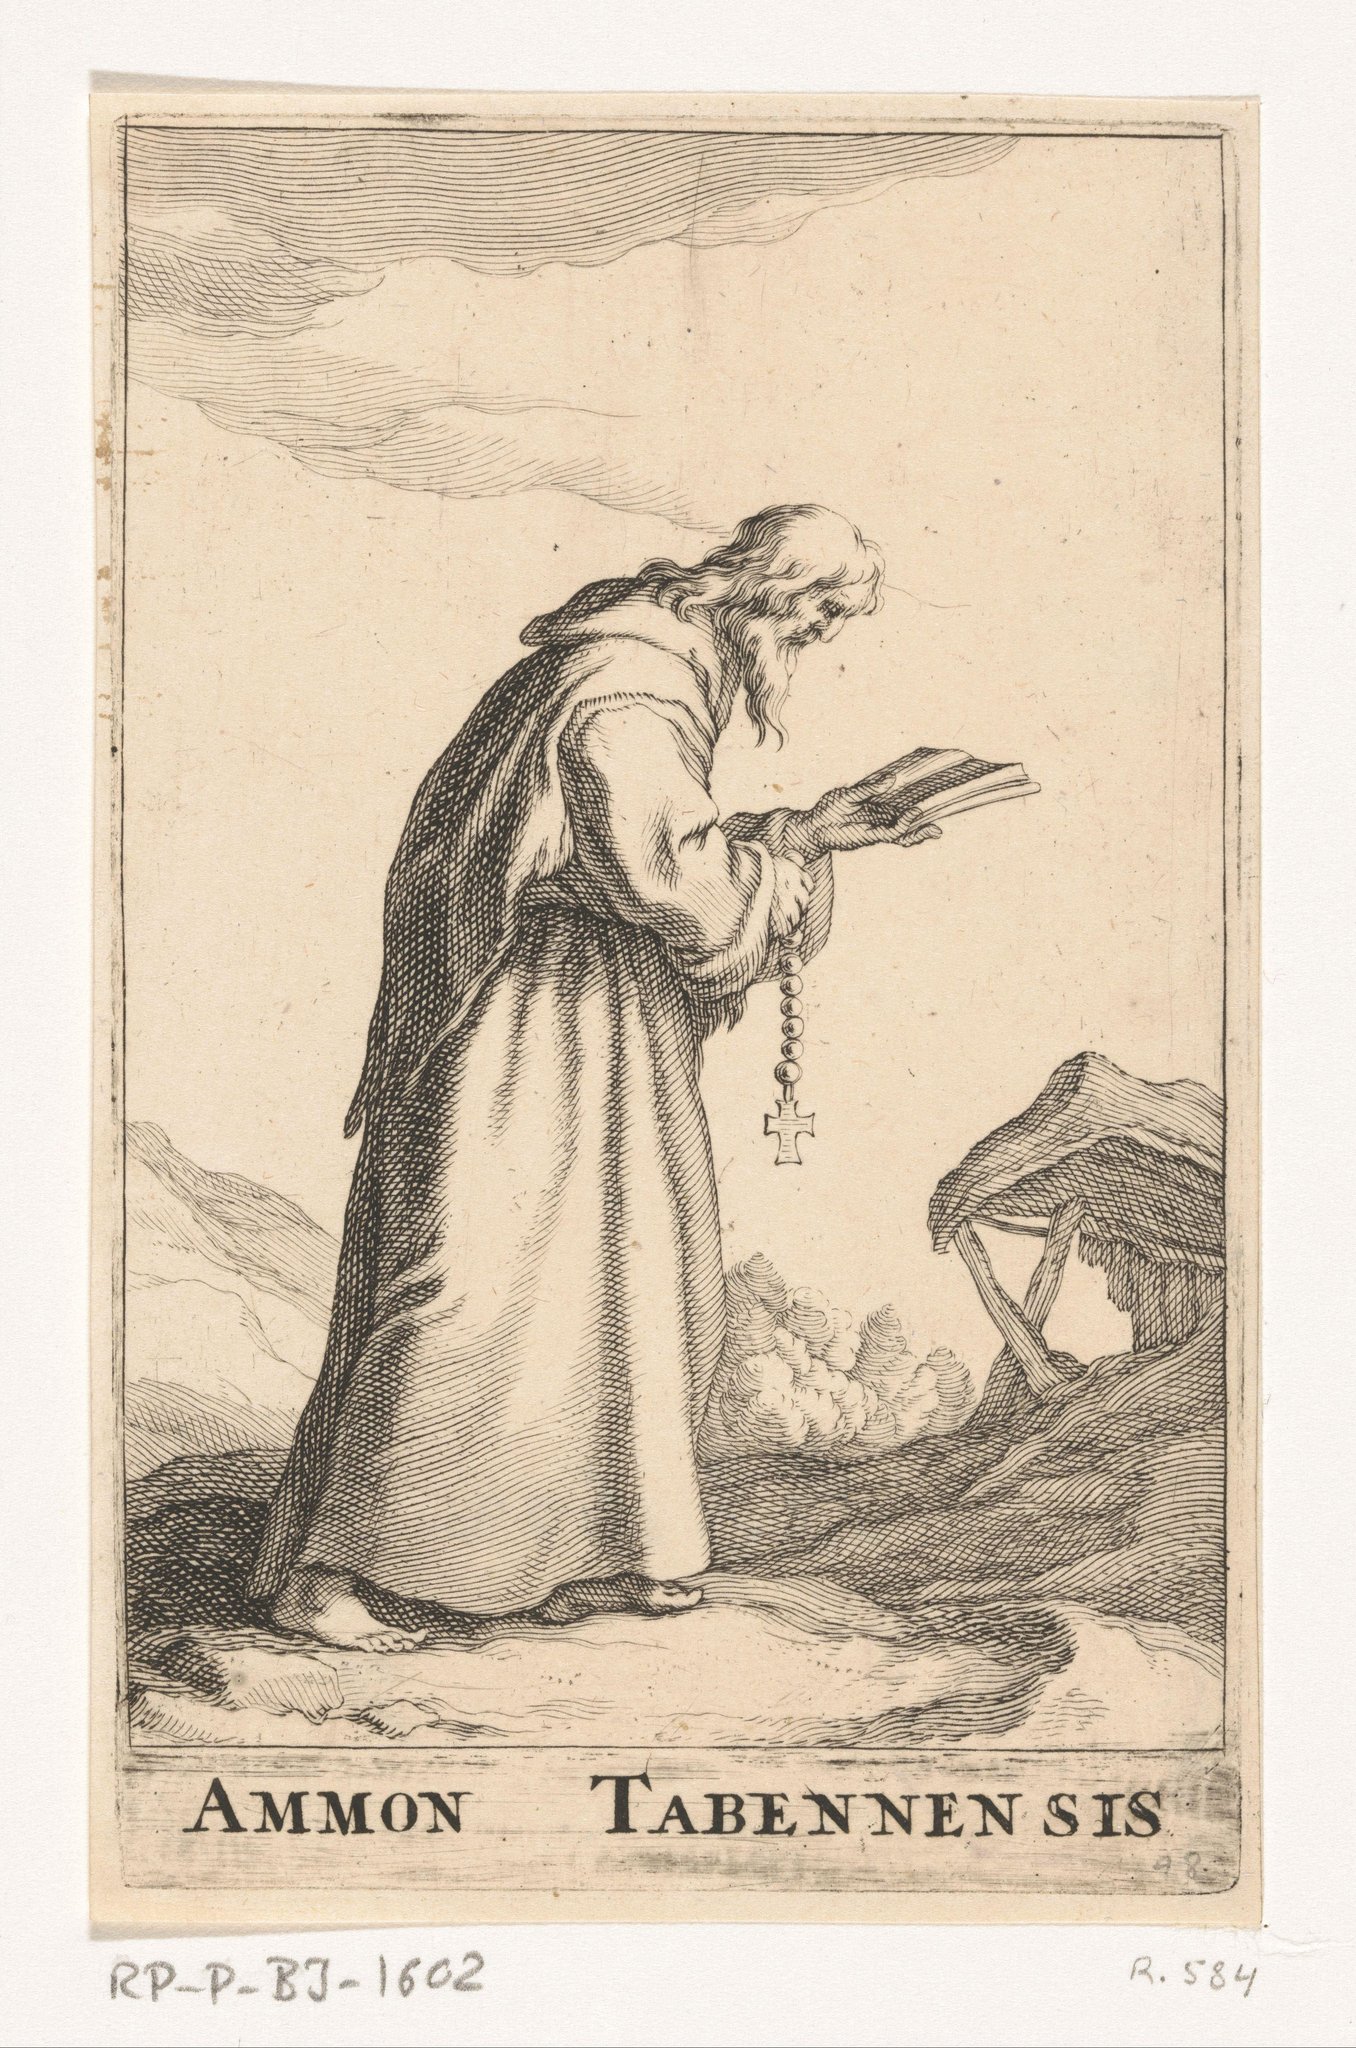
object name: print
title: Heilige Ammon van Tabennae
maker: frederick bloemaert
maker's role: print maker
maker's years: 1614-1669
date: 1636-1670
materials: paper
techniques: engraving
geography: utrecht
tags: male saints (ammon of tabennae)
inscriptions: collector's mark: Lugt 240, number: ‘48’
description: De heilige Ammon van Tabennae, prior van een groot klooster, leest staande in een boek. Prent uit een serie van 80 prenten en een titelprent met kluizenaars uit de 2e tot de 6e eeuw.